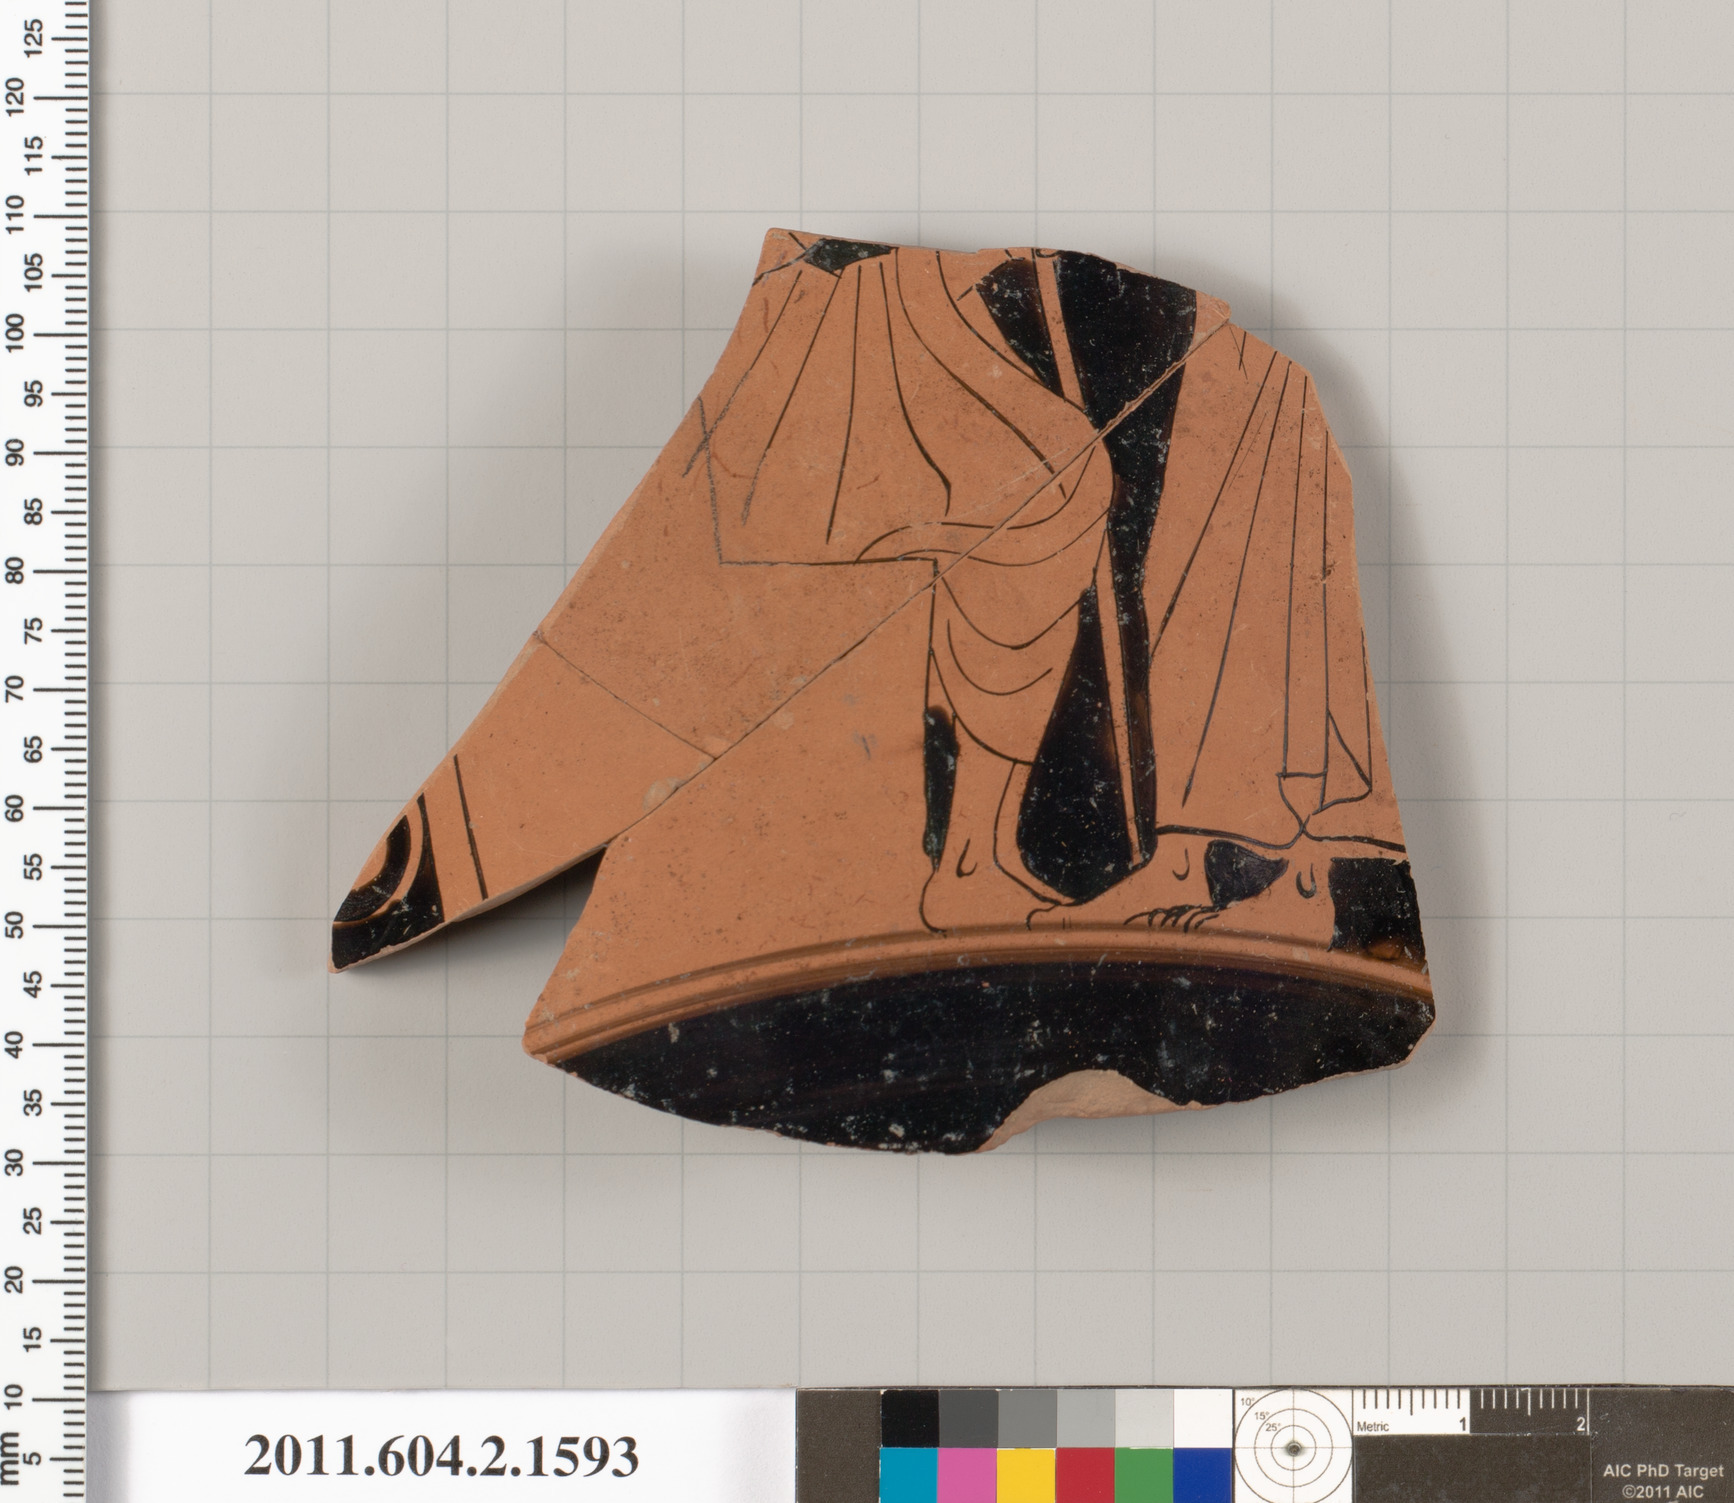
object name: skyphos fragment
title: Terracotta fragment of a skyphos (deep drinking cup)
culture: greek, attic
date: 460-440 BCE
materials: terracotta